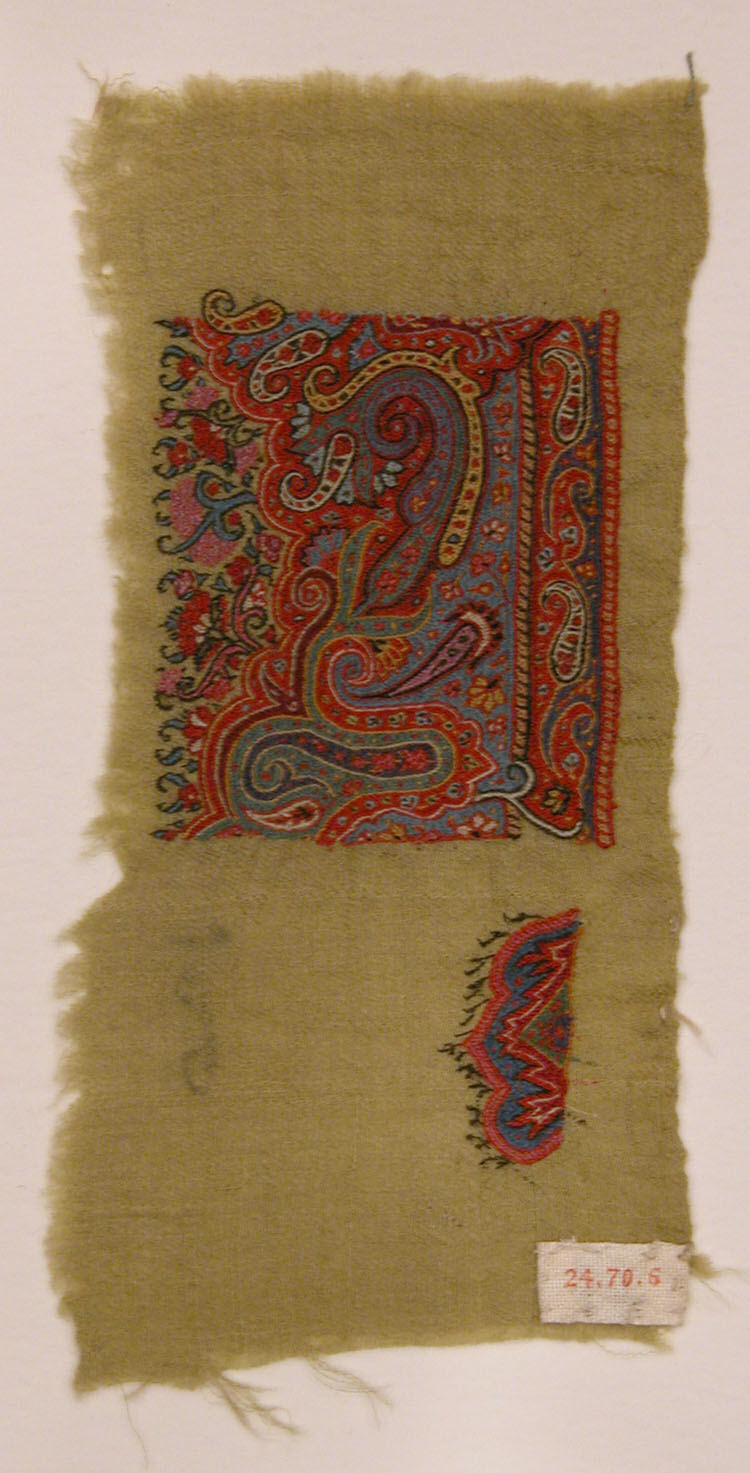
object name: shawl sample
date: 1801-1833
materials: wool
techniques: embroidery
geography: india